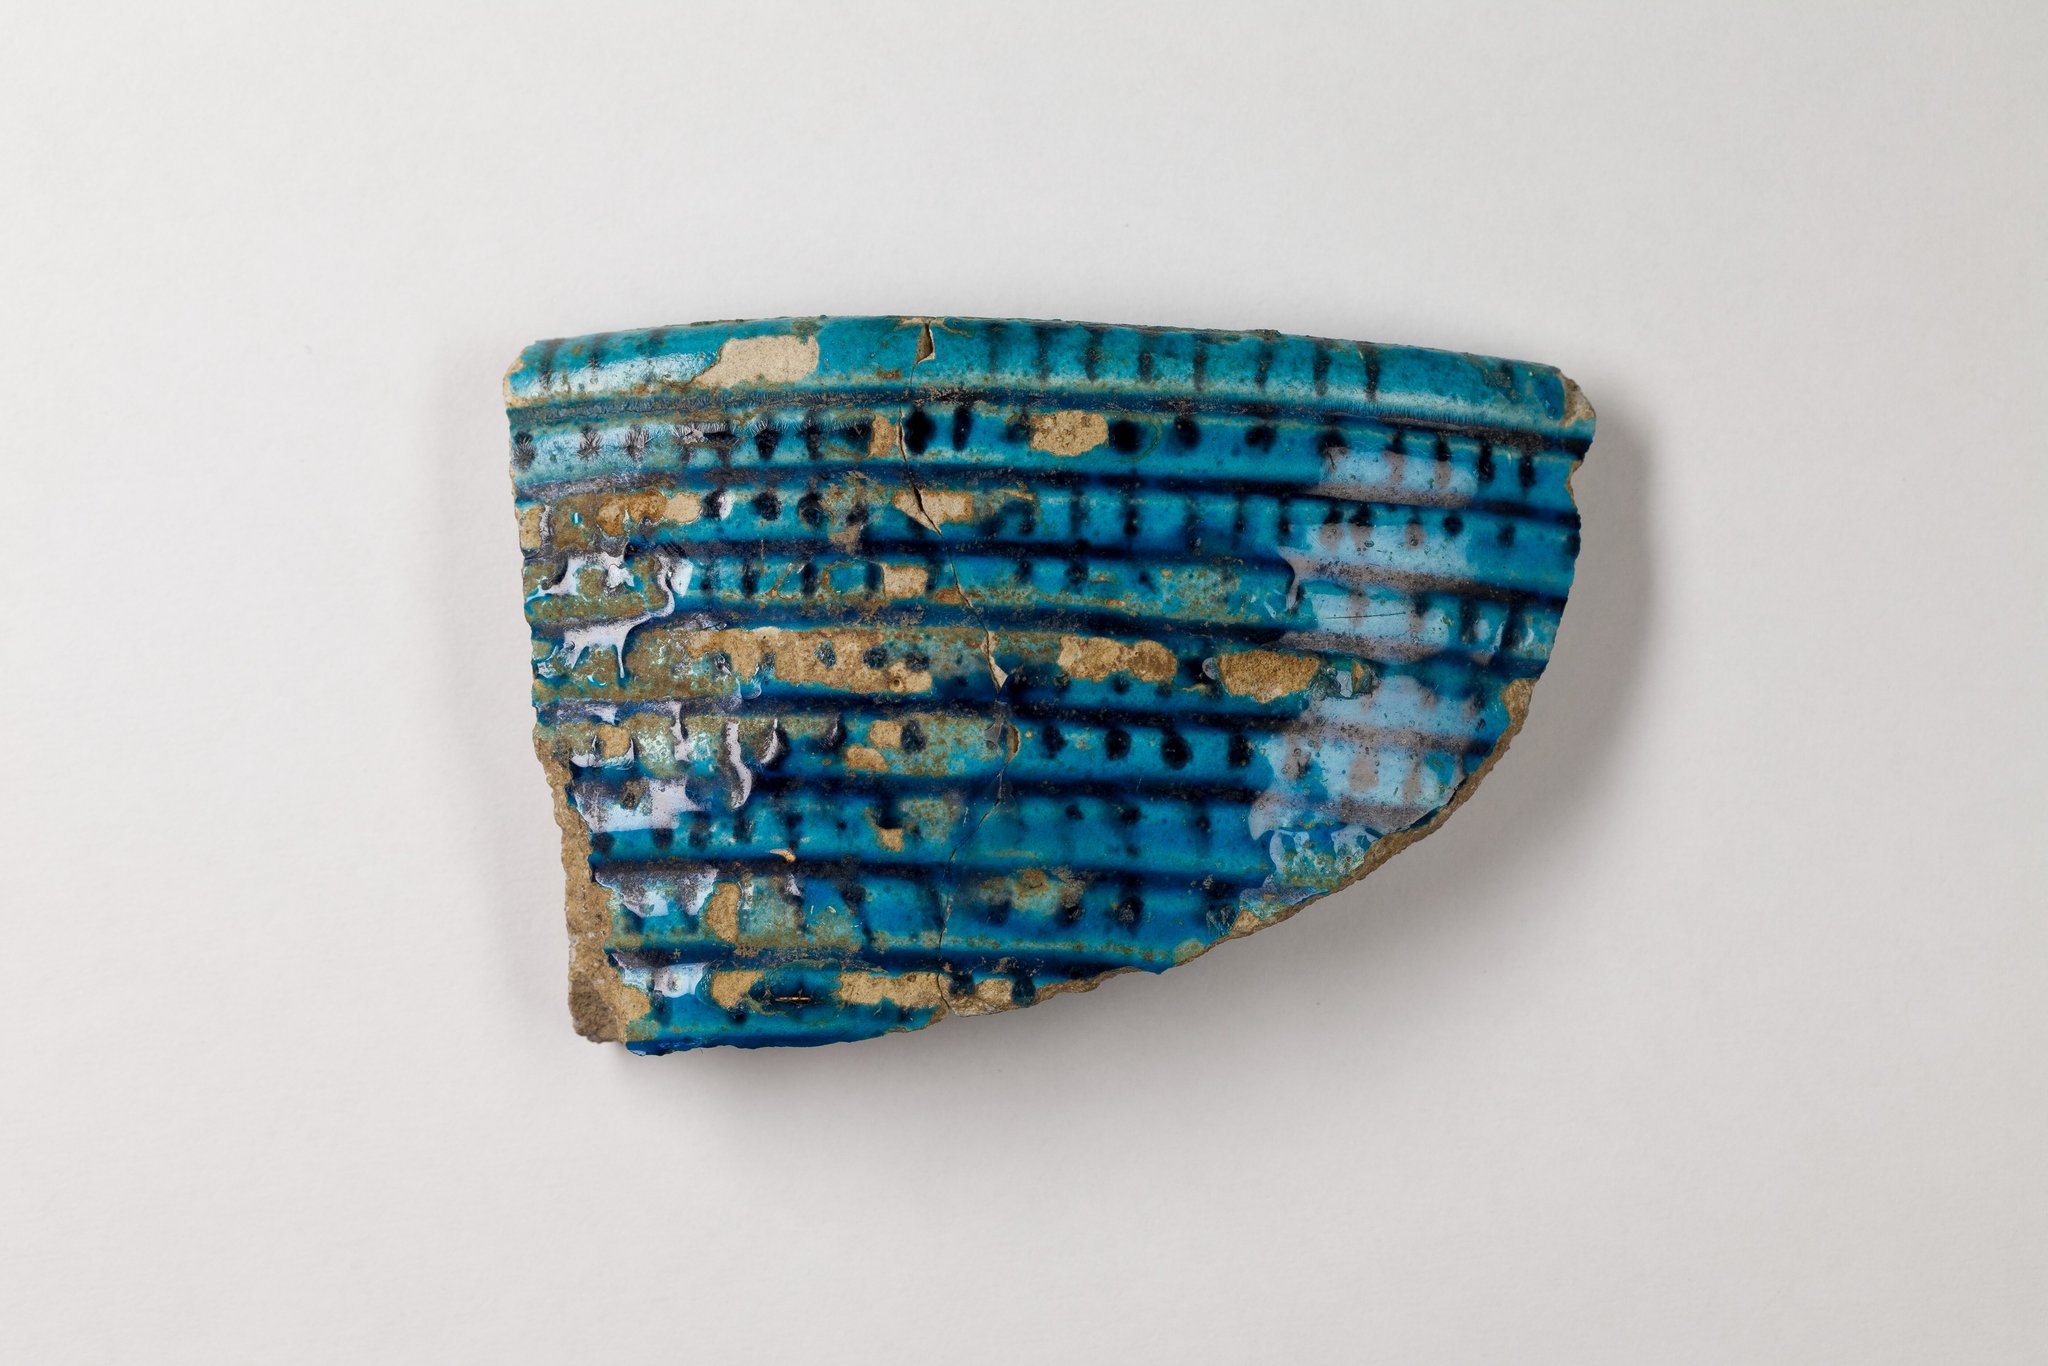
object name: vase fragment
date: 1981-1640 BCE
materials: faience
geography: egypt